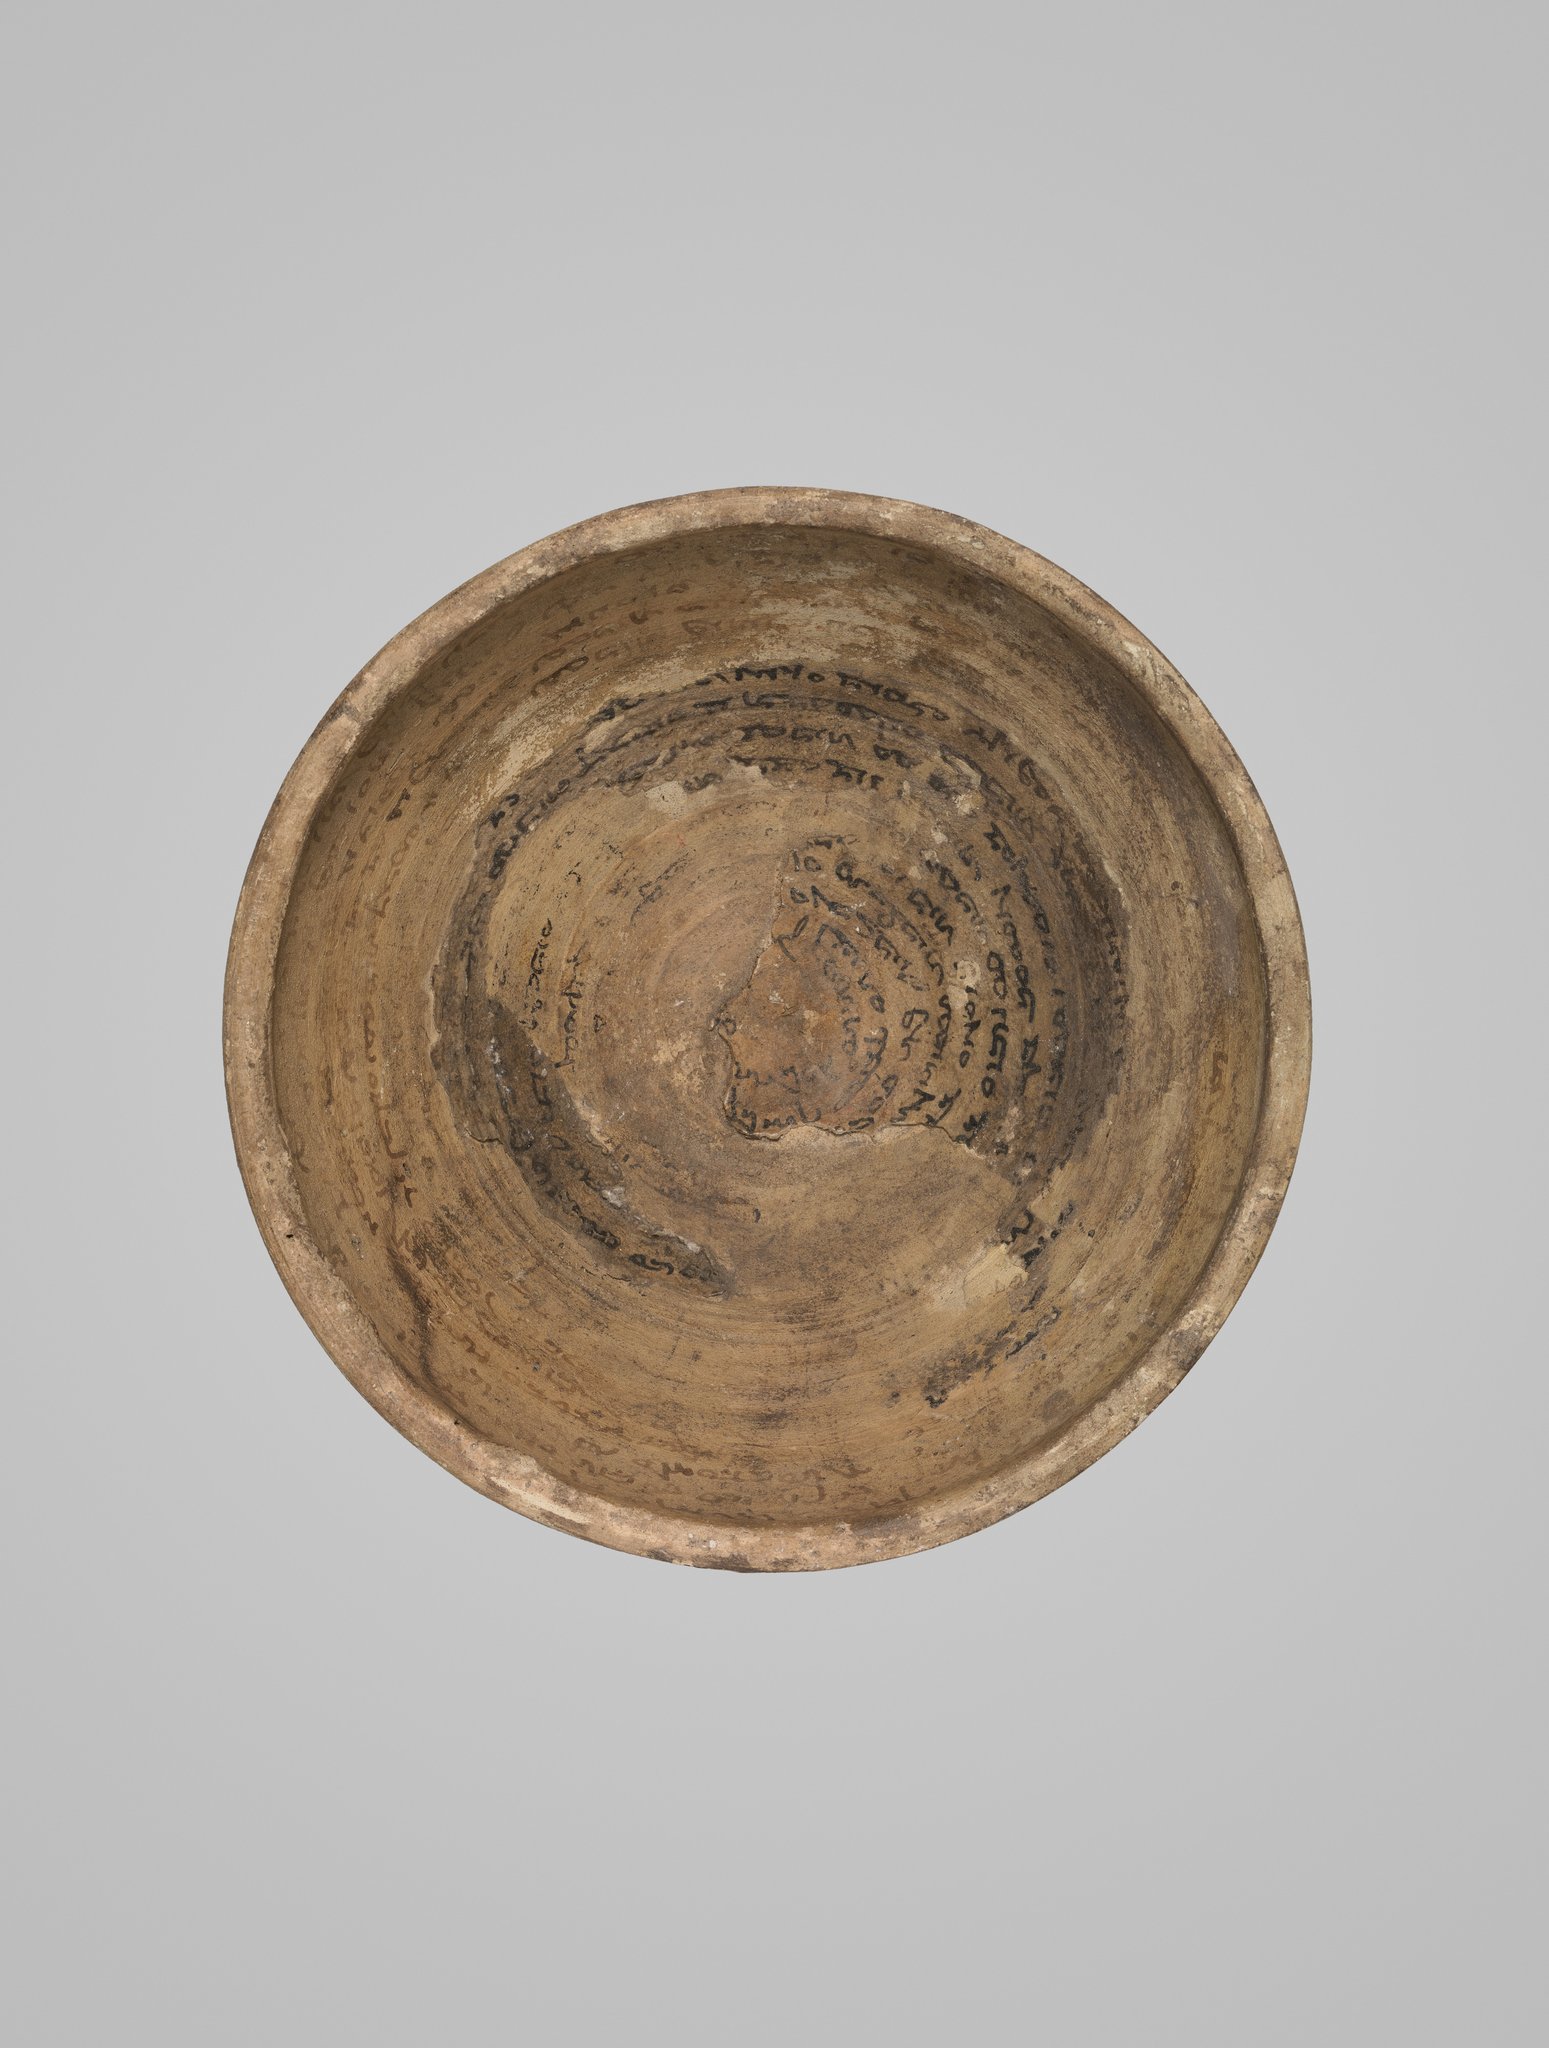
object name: bowl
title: Incantation bowl with Mandaic inscription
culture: sasanian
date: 401-600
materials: ceramic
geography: mesopotamia